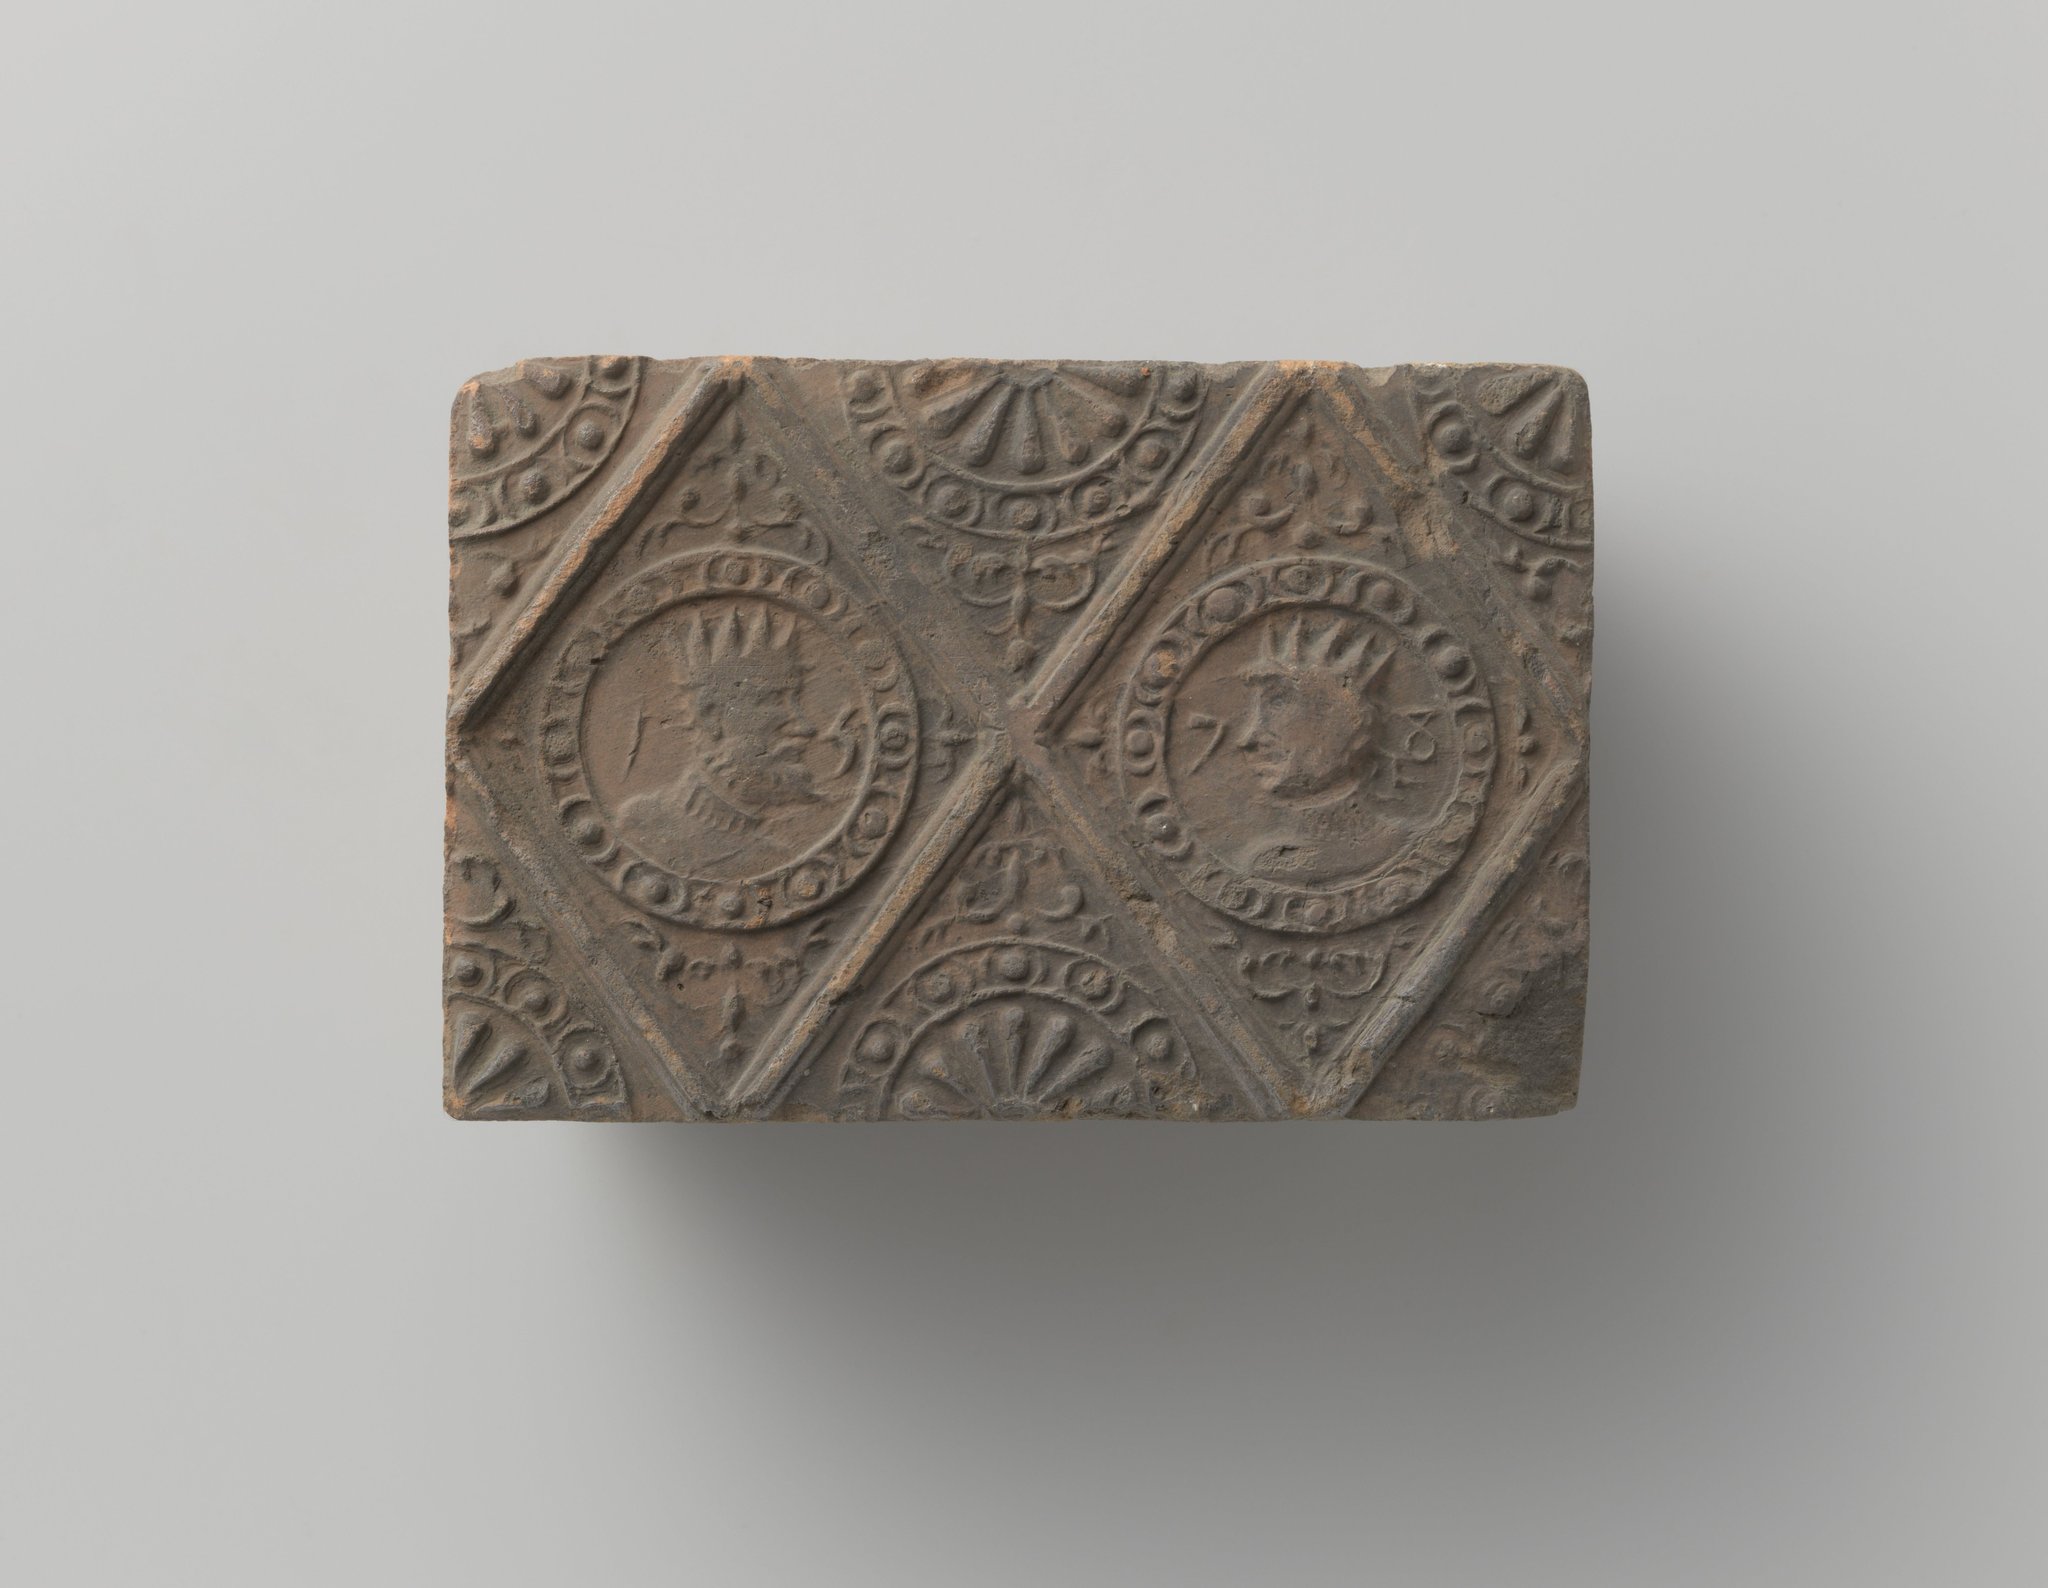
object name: hearthstone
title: Haardsteen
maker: Anonymous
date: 1581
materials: earthenware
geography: southern netherlands